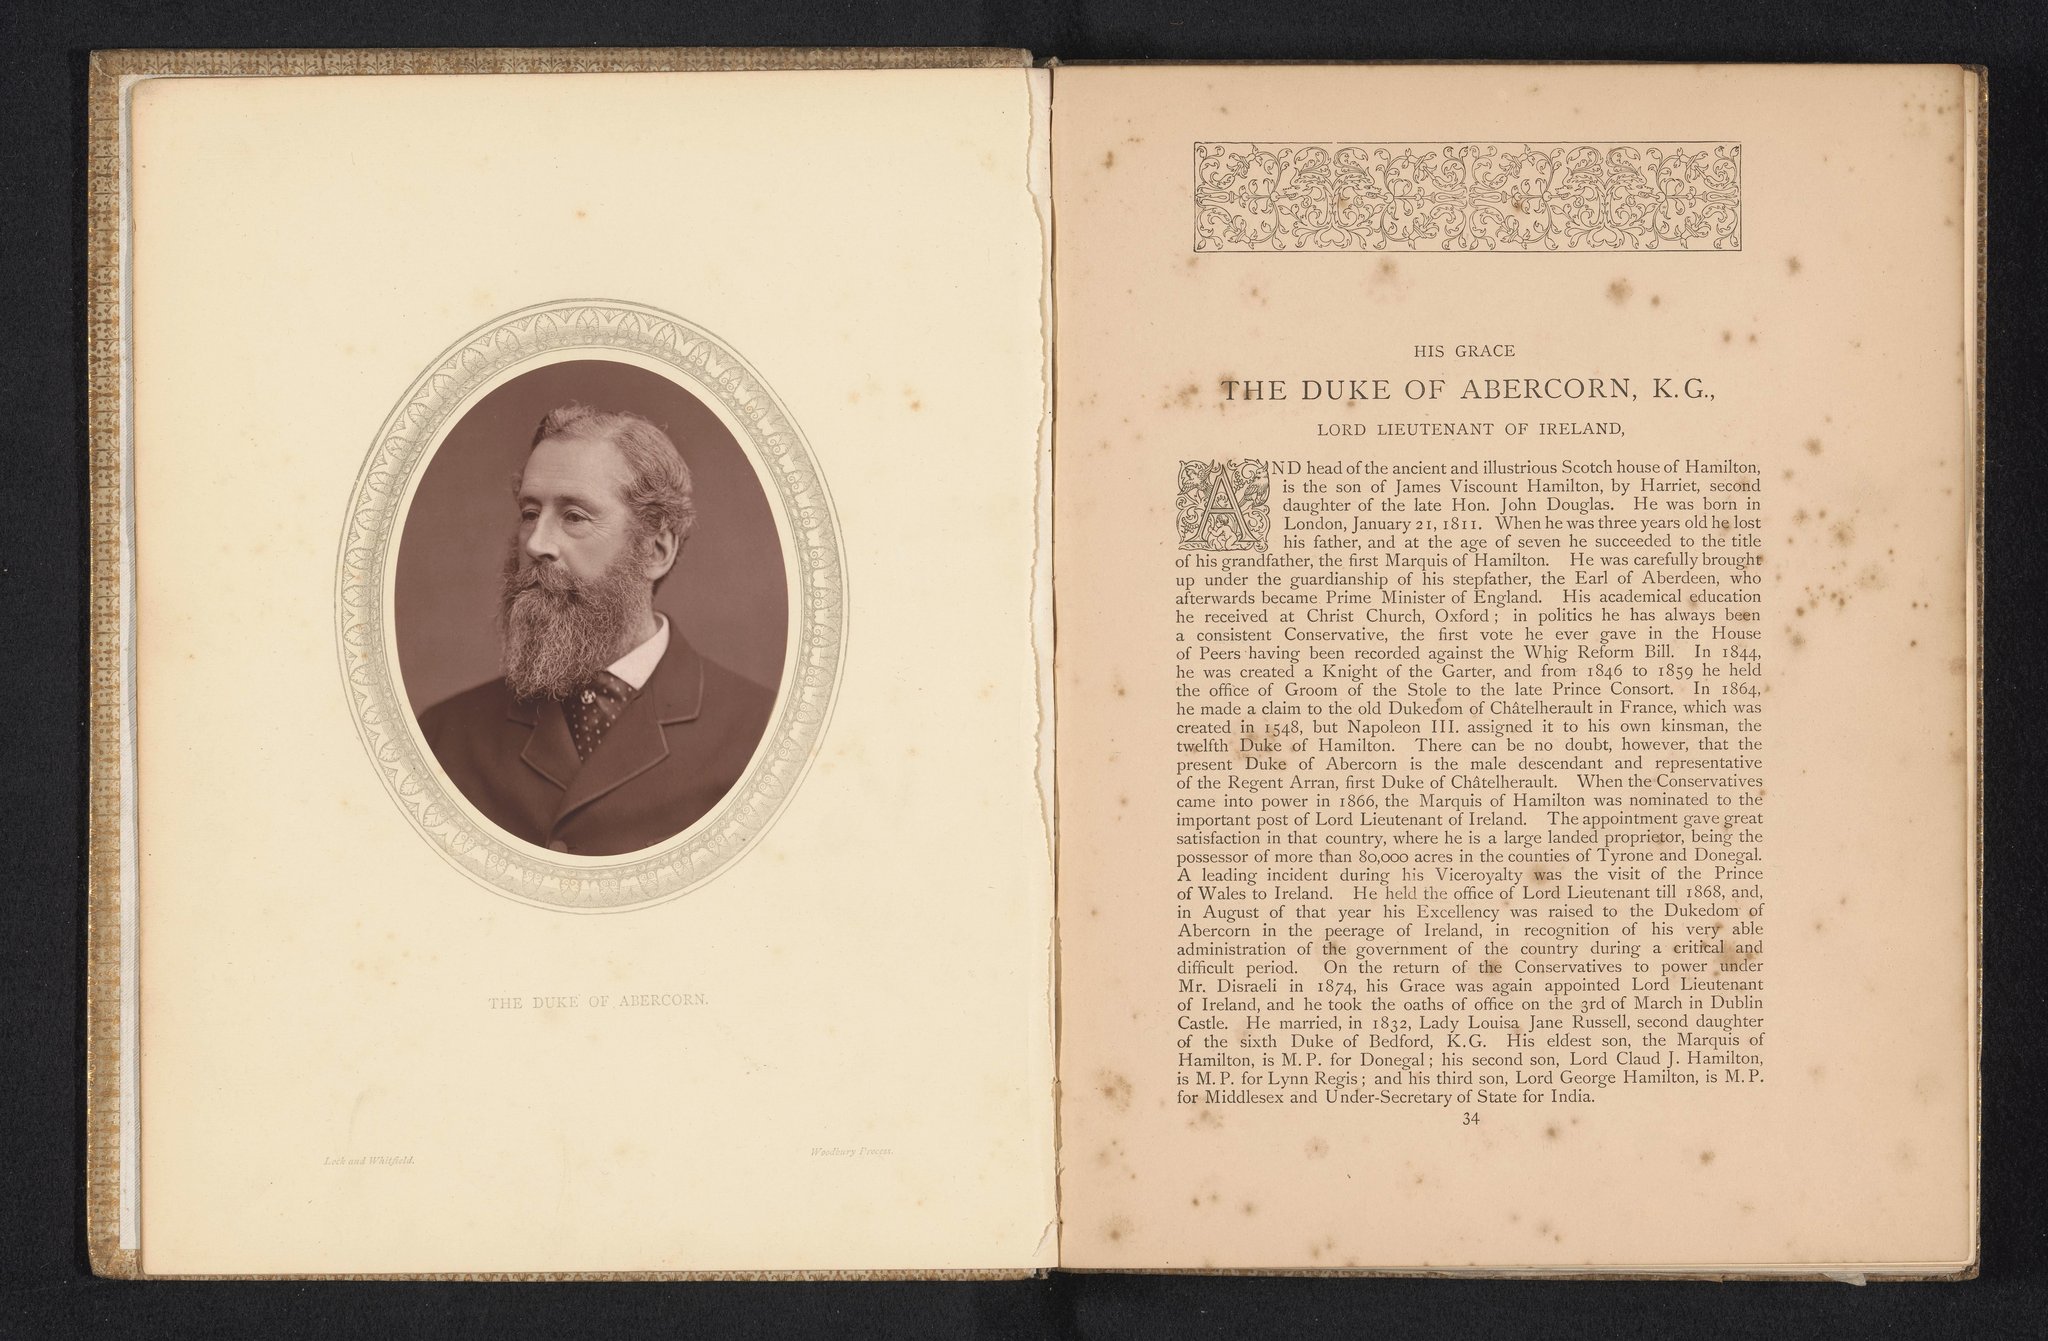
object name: page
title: The duke of Abercorn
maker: Anonymous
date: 1871-1876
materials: paper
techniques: woodburytype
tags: historical persons (portraits and scenes from the life) (+ (full) bust portrait)